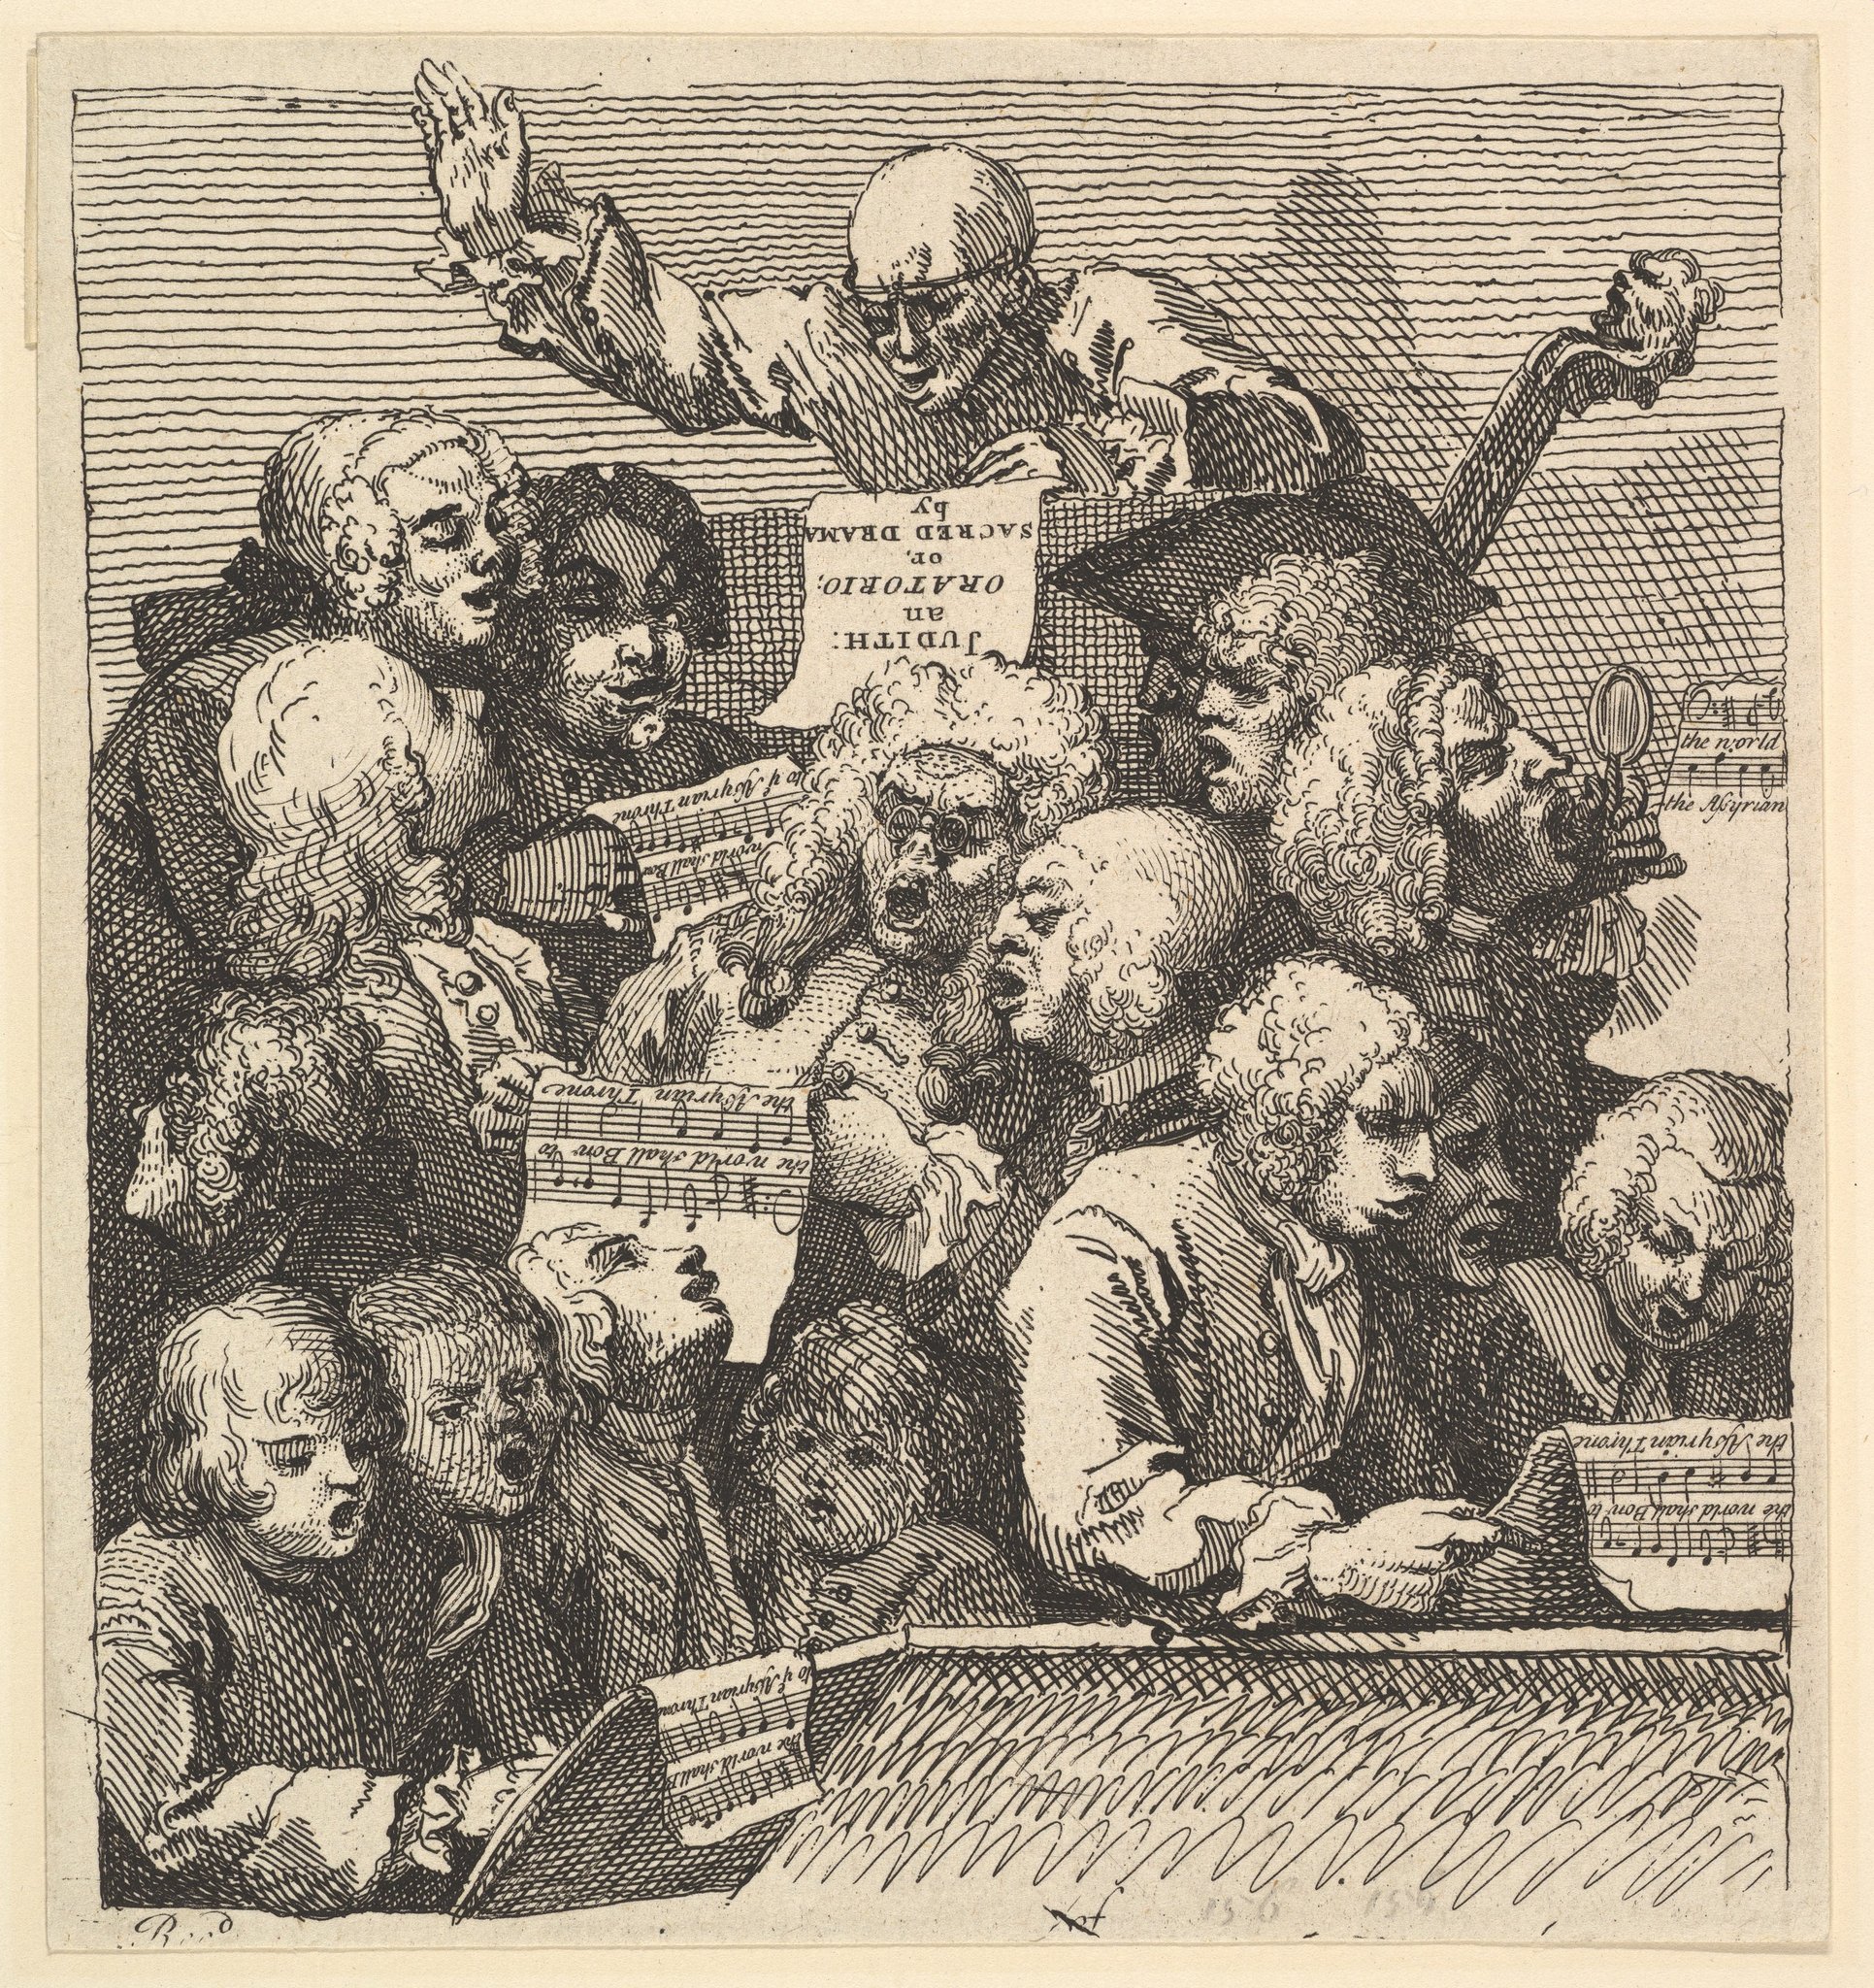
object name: print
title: A Chorus of Singers, or The Oratorio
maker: william hogarth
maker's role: artist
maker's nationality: british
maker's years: 1697-1764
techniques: etching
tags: men,women,music,singers